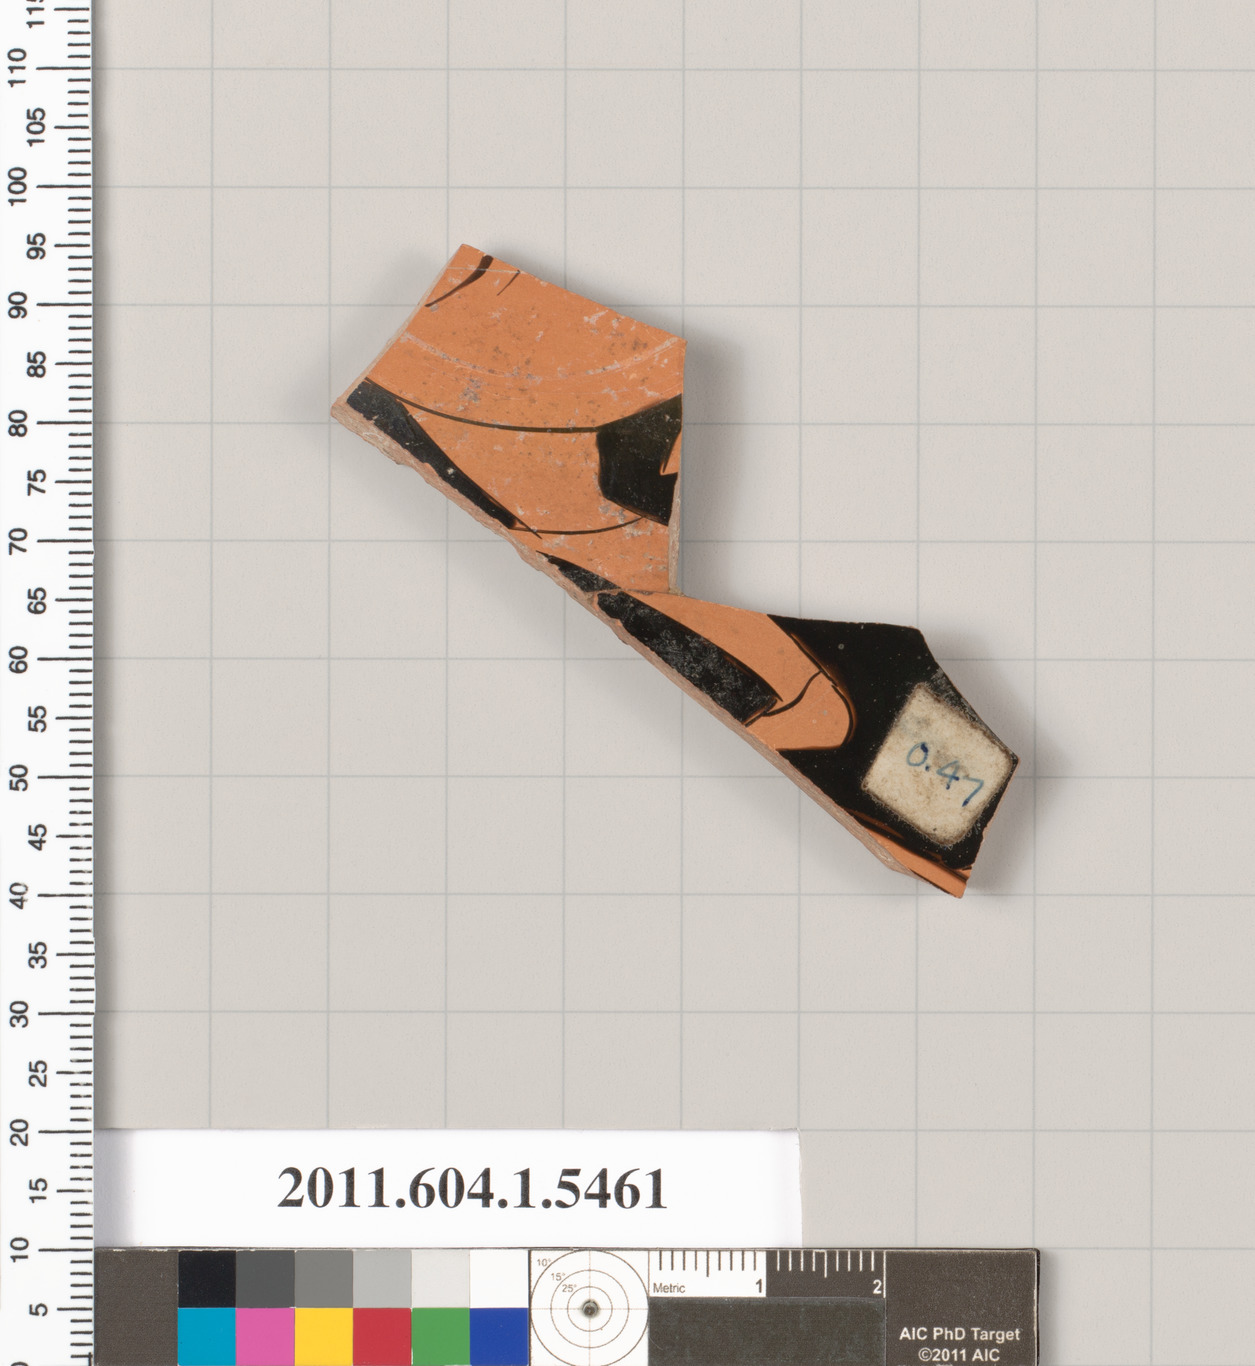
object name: kylix fragment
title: Terracotta fragment of a kylix (drinking cup)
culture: greek, attic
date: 520-500 BCE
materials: terracotta